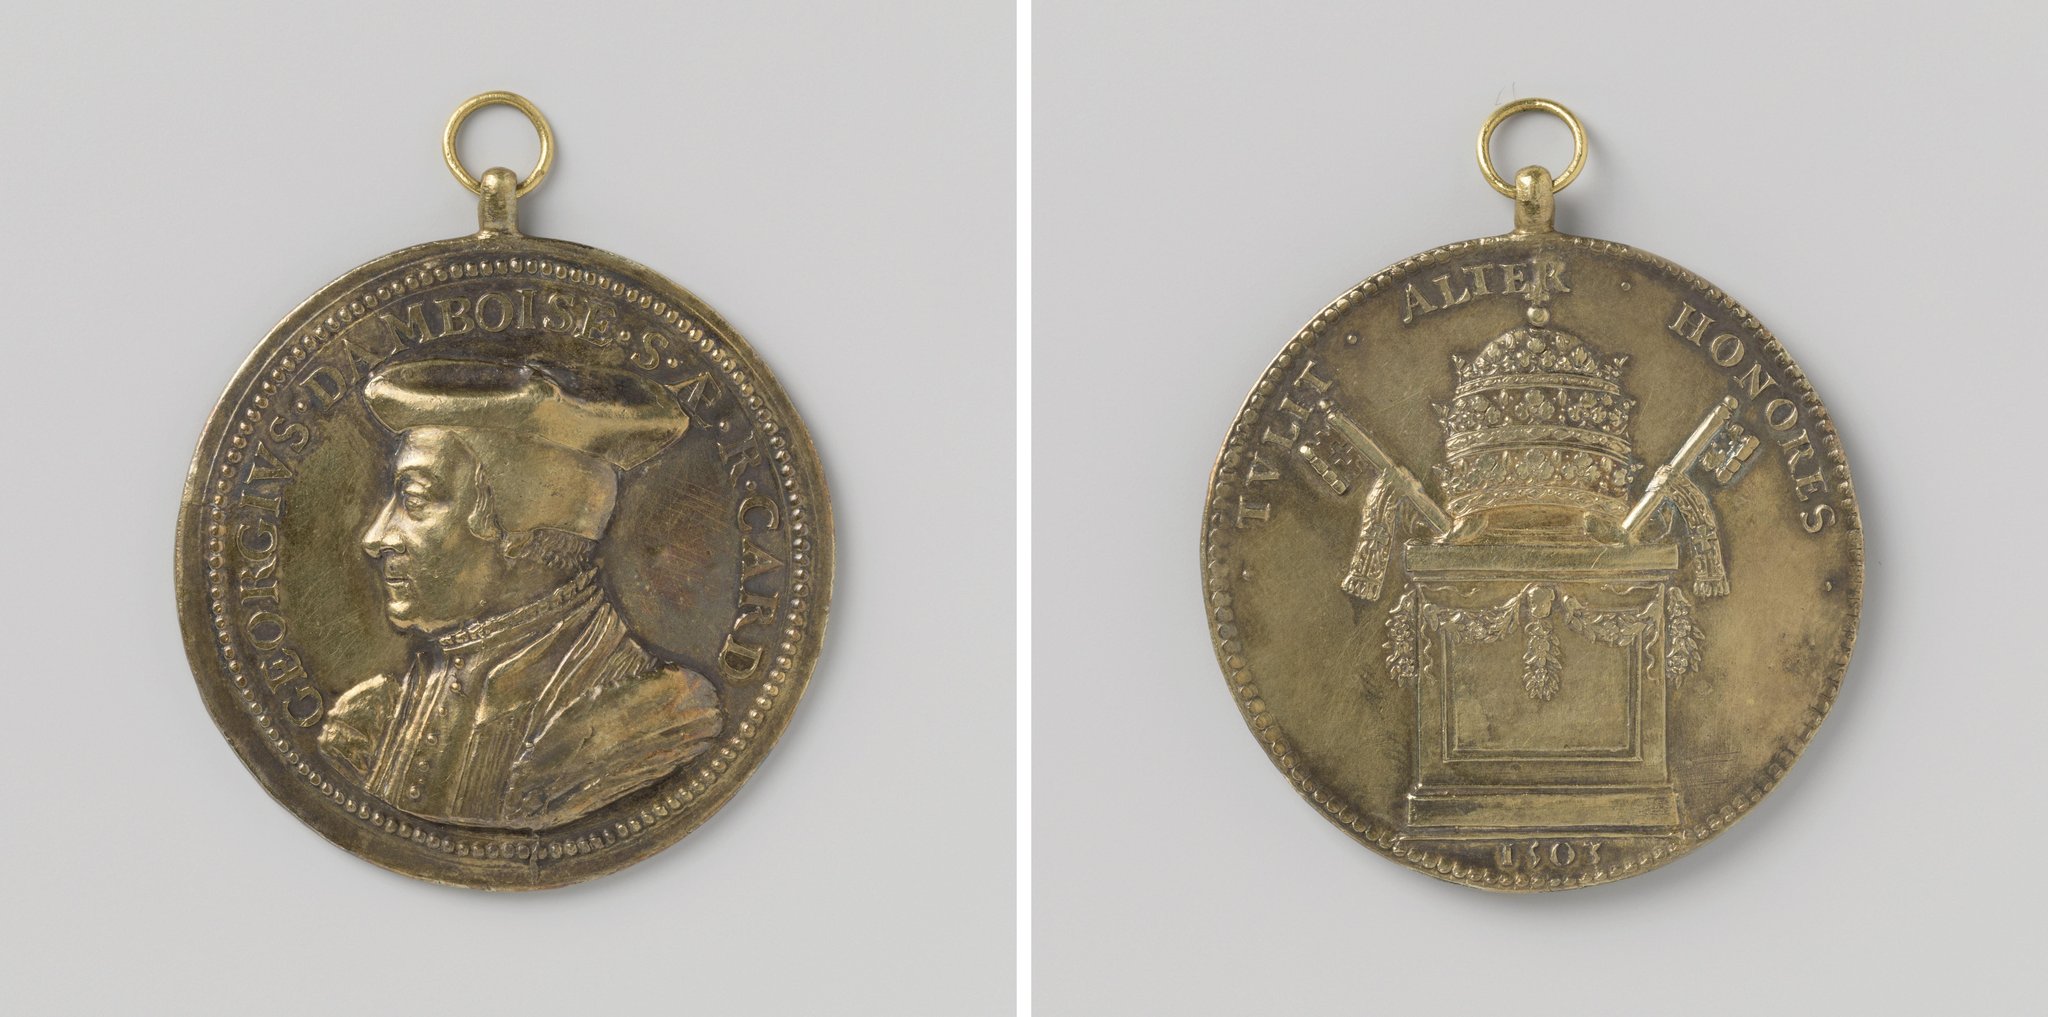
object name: history medal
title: Kardinaal George d'Amboise tot twee maal toe niet tot paus gekozen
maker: pierre regnier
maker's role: medailleur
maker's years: 1577-1640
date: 1634-1640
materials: silver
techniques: gilding, striking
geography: paris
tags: aartsbisschop, georges d' amboise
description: Zilveren penning met draagoog en draagring. Voorzijde: borststuk man met kardinaalsmuts binnen omschrift. Keerzijde: pauselijke tiara liggend op voetstuk tussen twee sleutels binnen omschrift